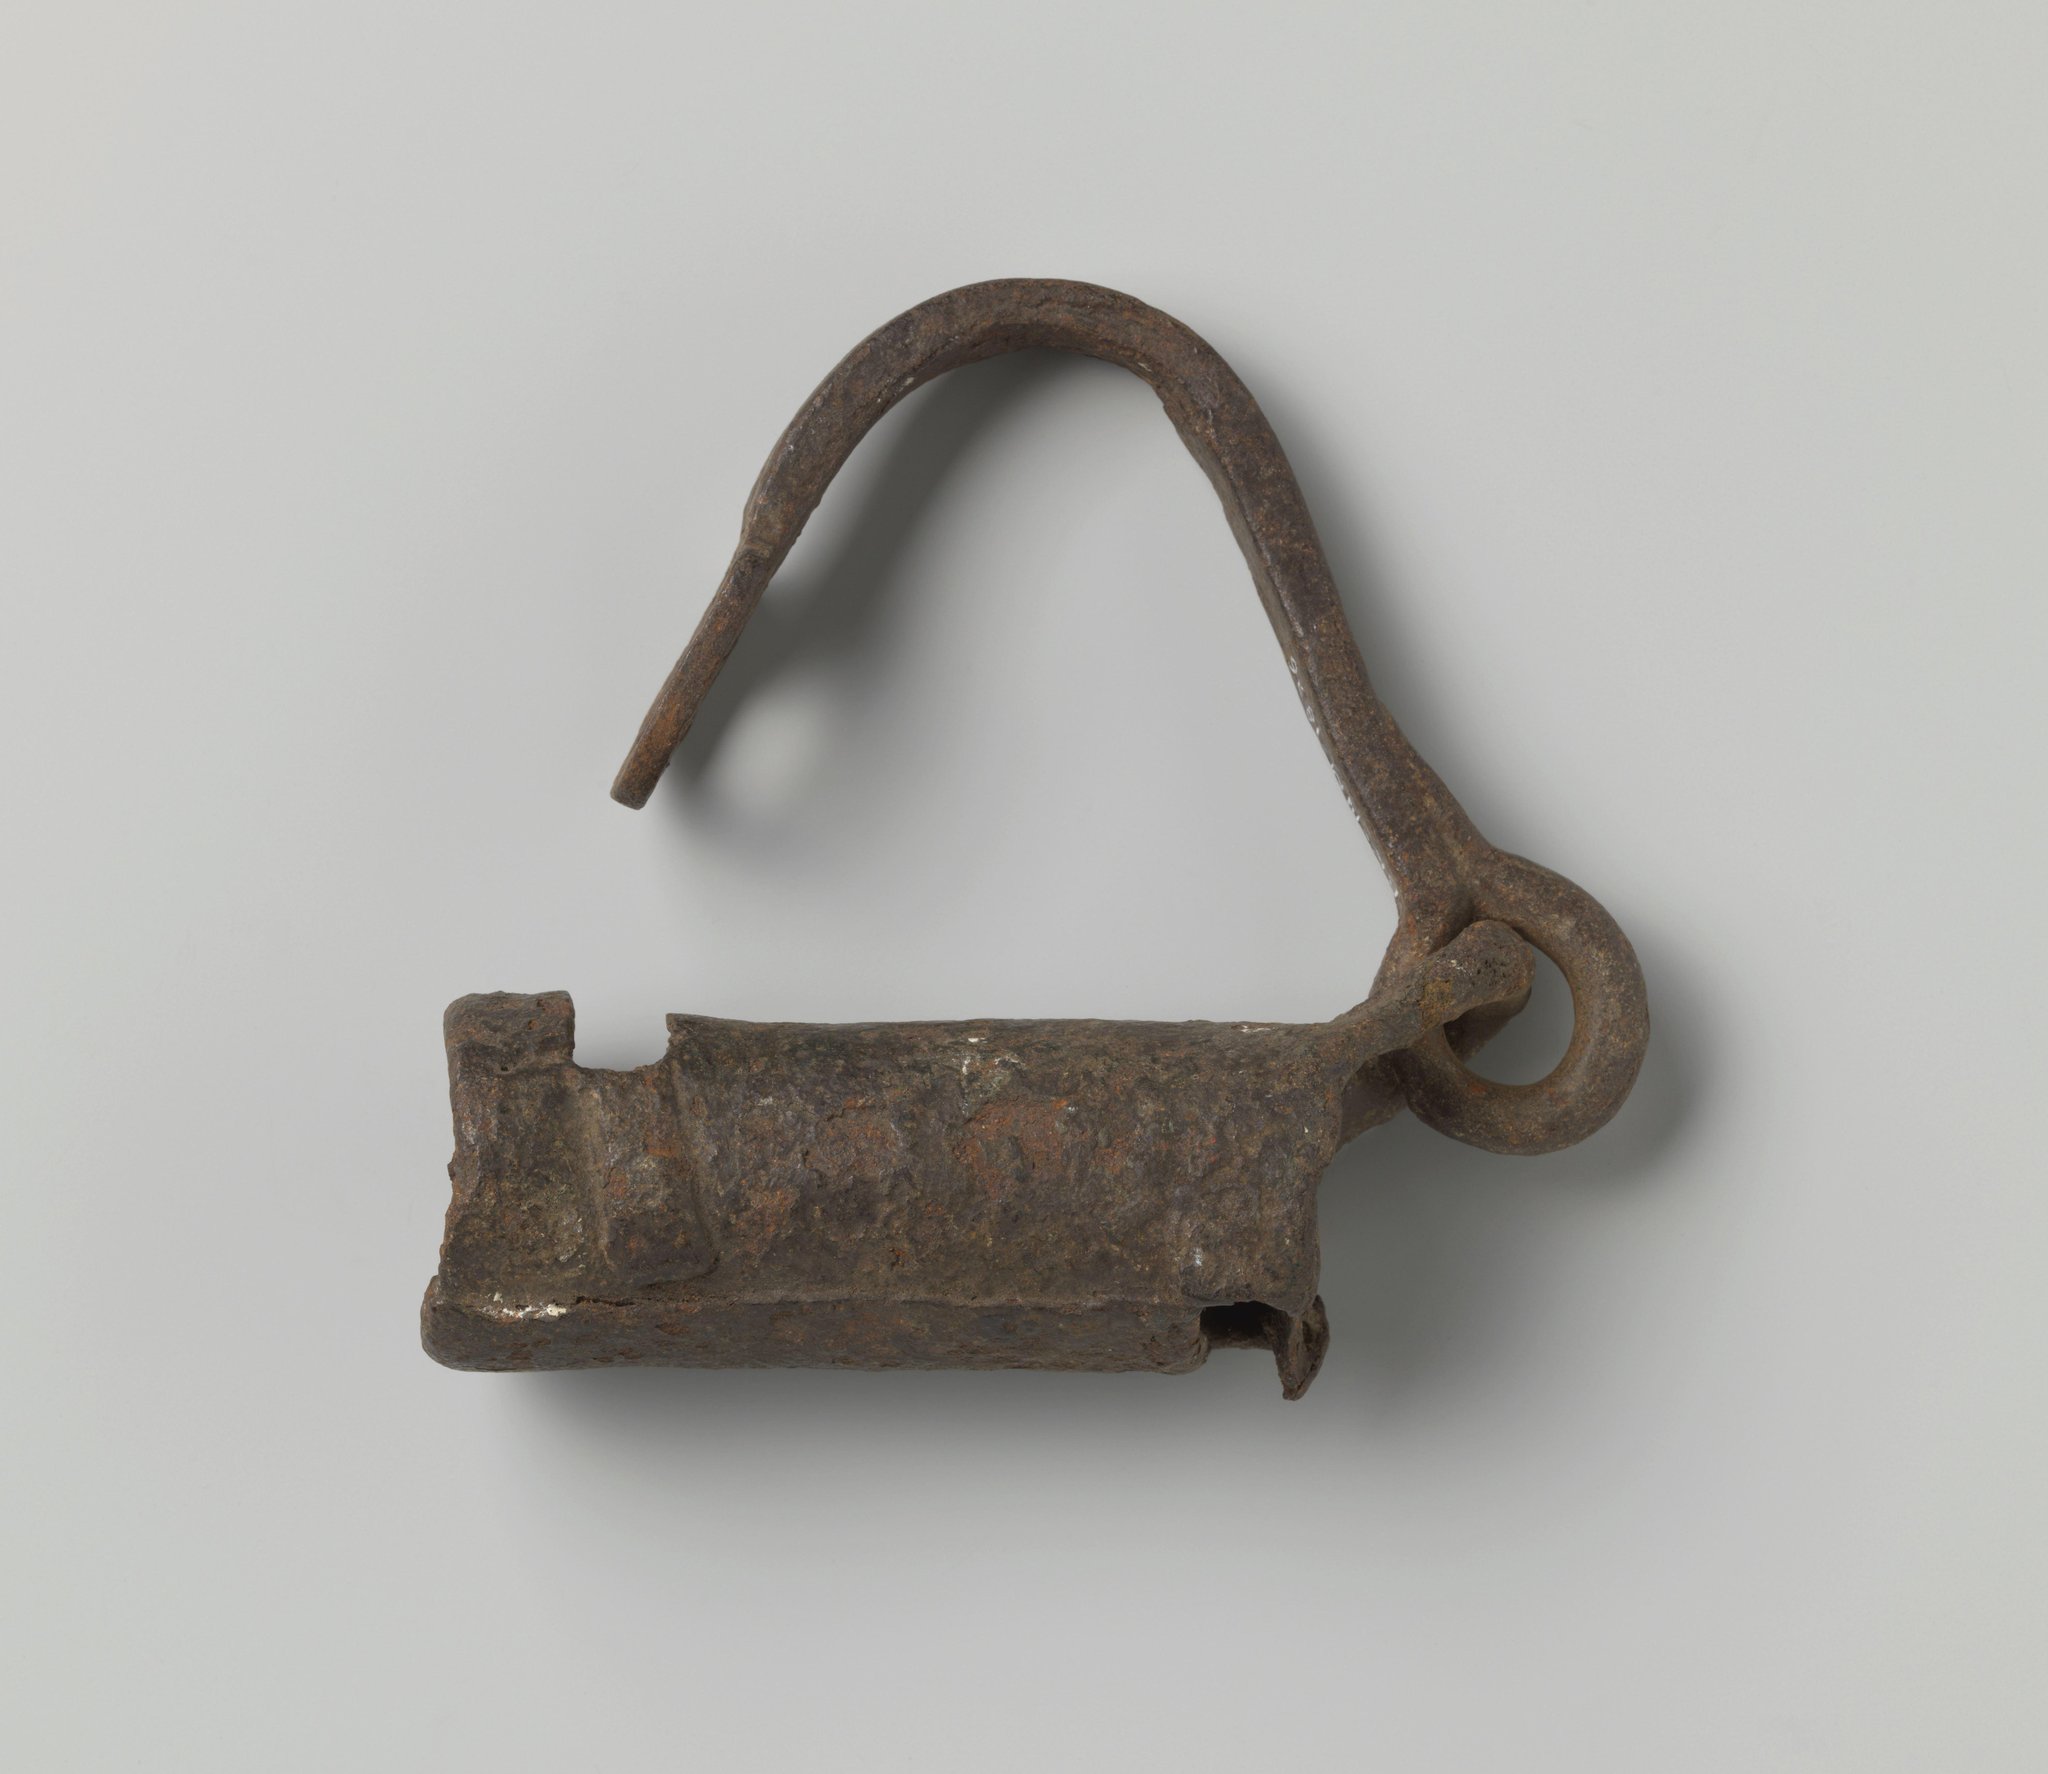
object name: padlock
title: Hangslot van ijzer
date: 1400-1950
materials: iron